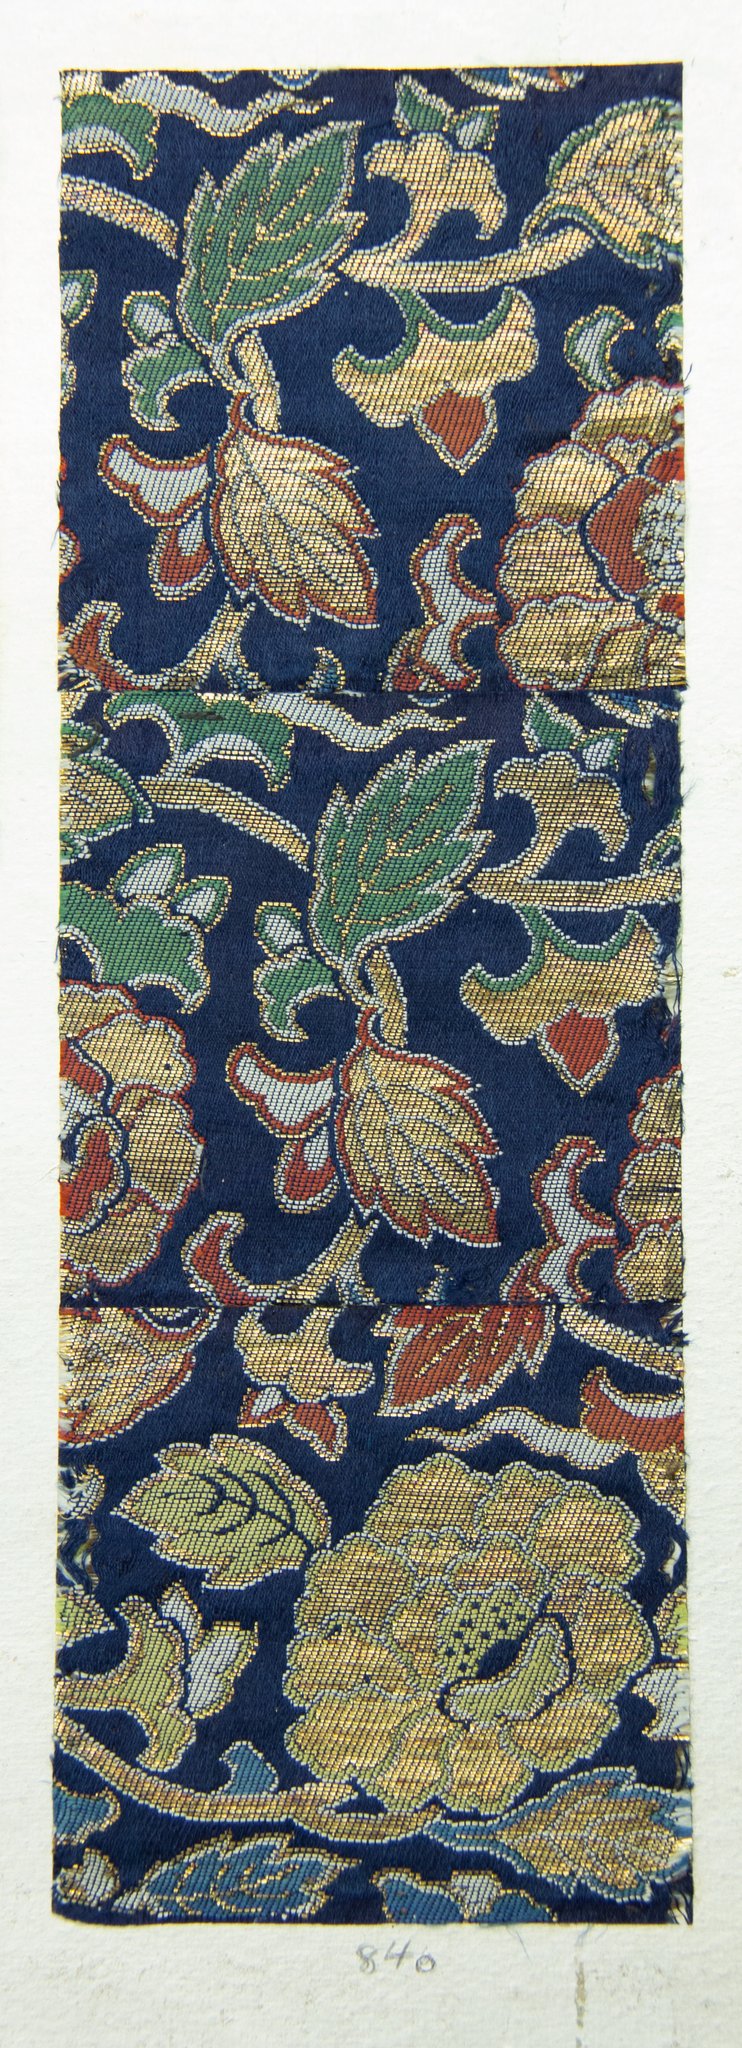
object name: piece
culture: china or japan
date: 1801-1900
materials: silk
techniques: compound weave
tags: flowers,leaves